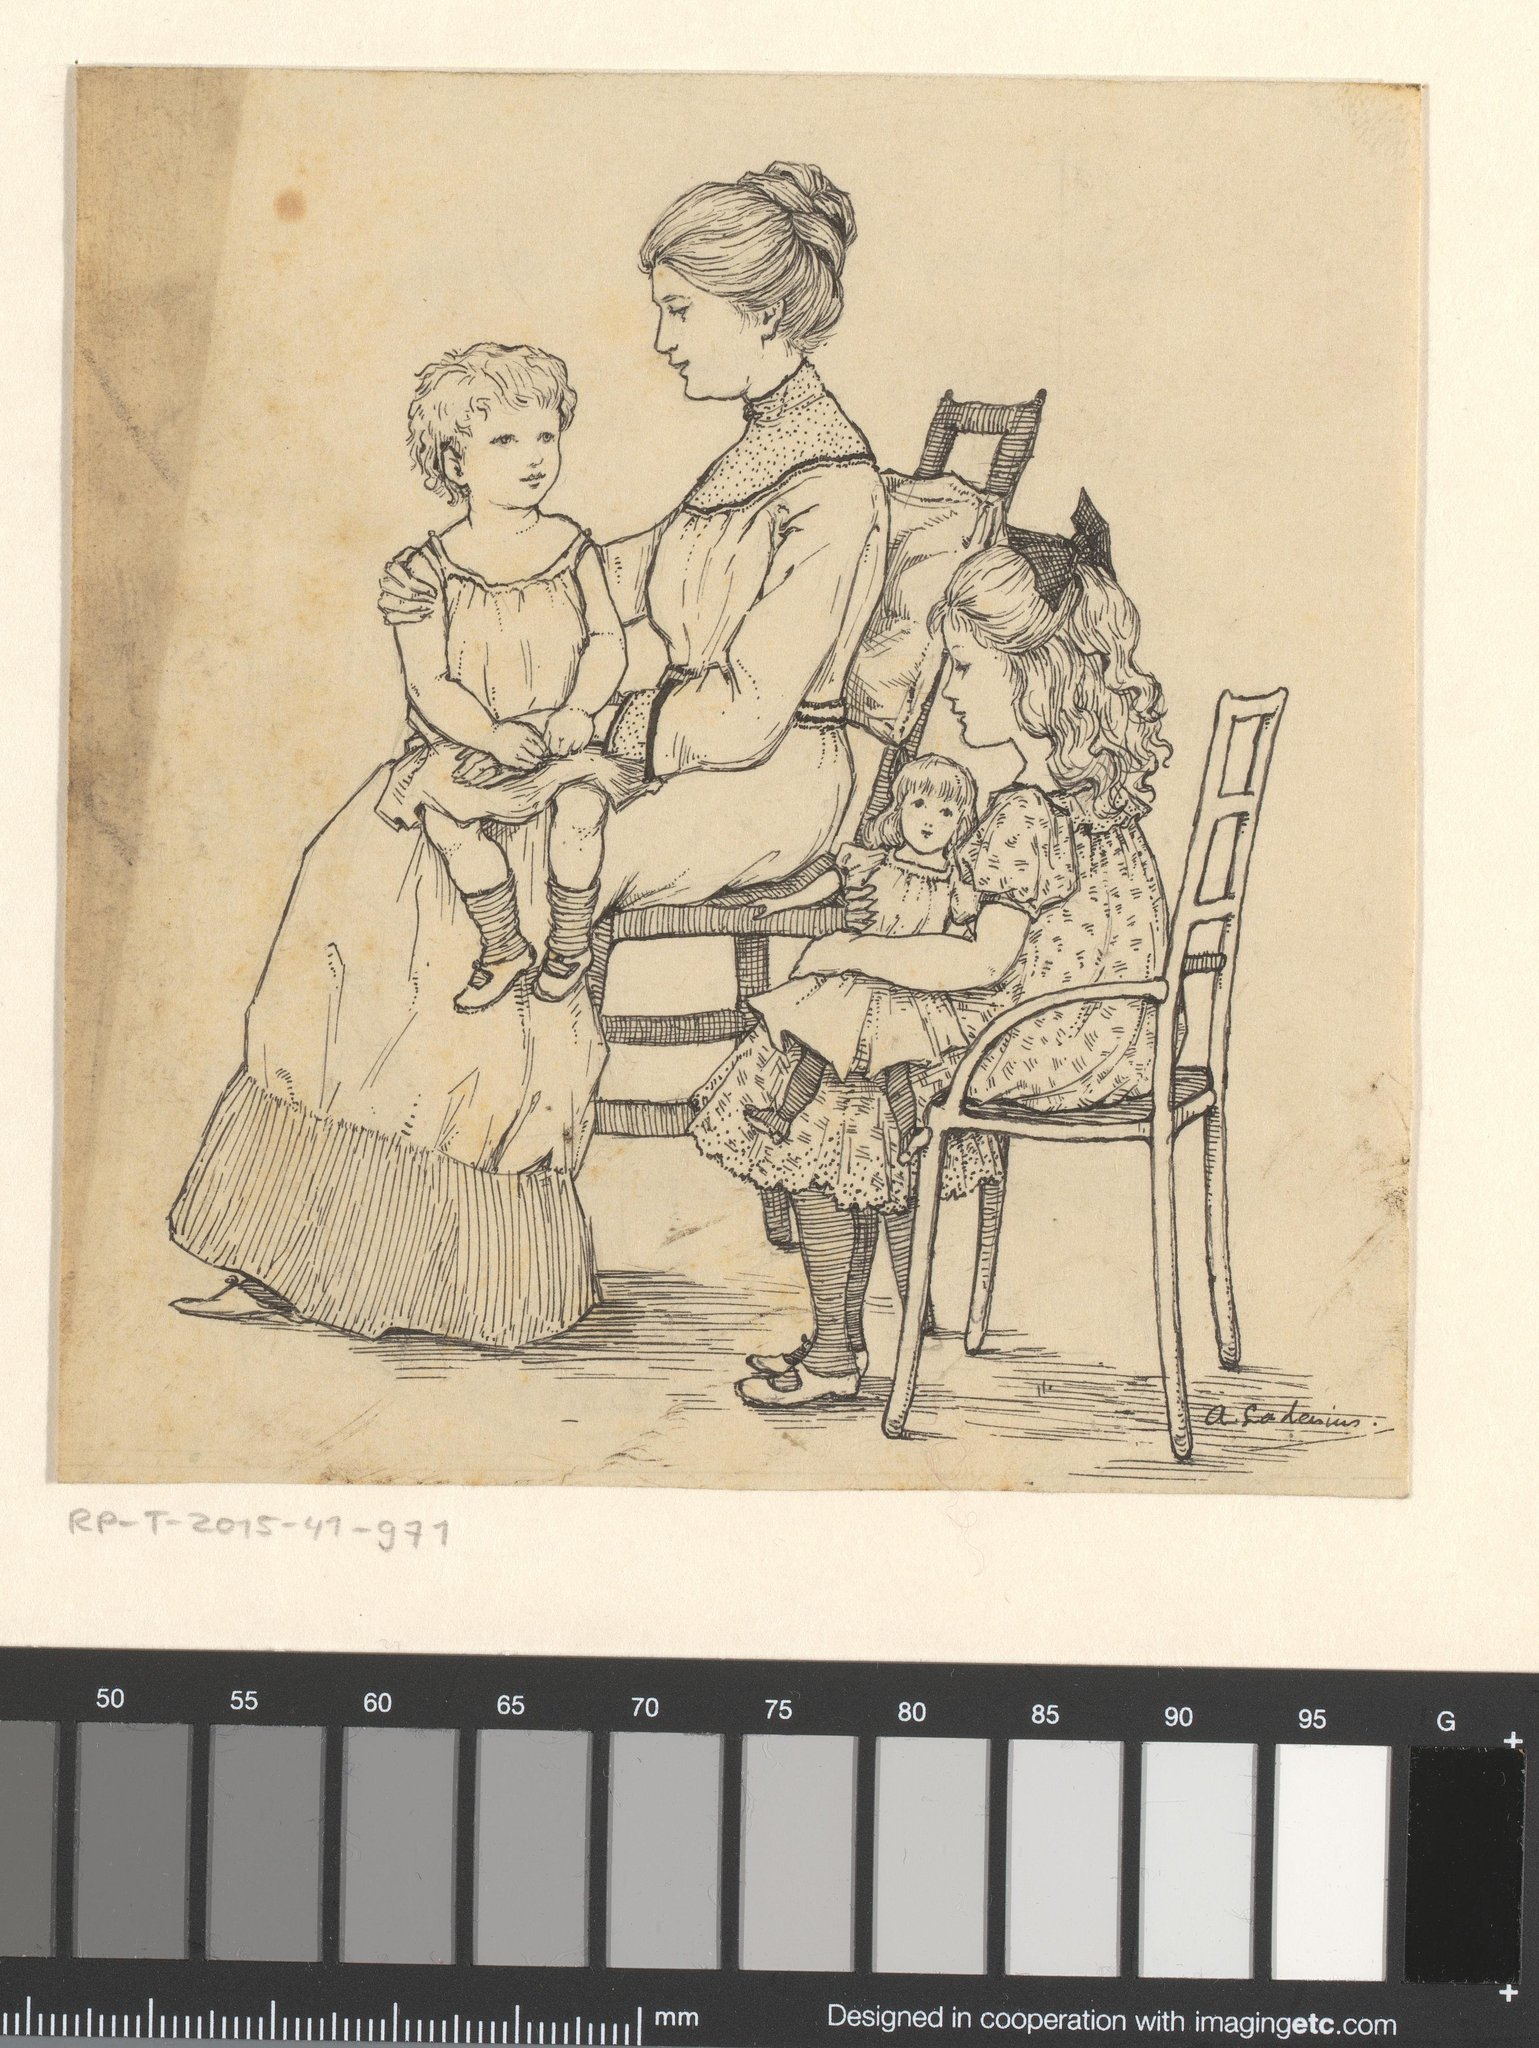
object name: boekillustratie ontwerp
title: Moeder met kind en meisje met pop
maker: adri ladenius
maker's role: draughtsman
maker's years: 1883-1953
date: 1893-1953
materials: ink, paper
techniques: pen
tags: (playing with) dolls, mother and baby or young child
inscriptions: annotation: ‘Twee moedertjes’, signature: ‘A. Ladenius.’, :, collector's mark: Lugt 2228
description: Een moeder zit op een stoel met een kind op schoot. Naast haar zit een meisje op een stoel met een pop op schoot.